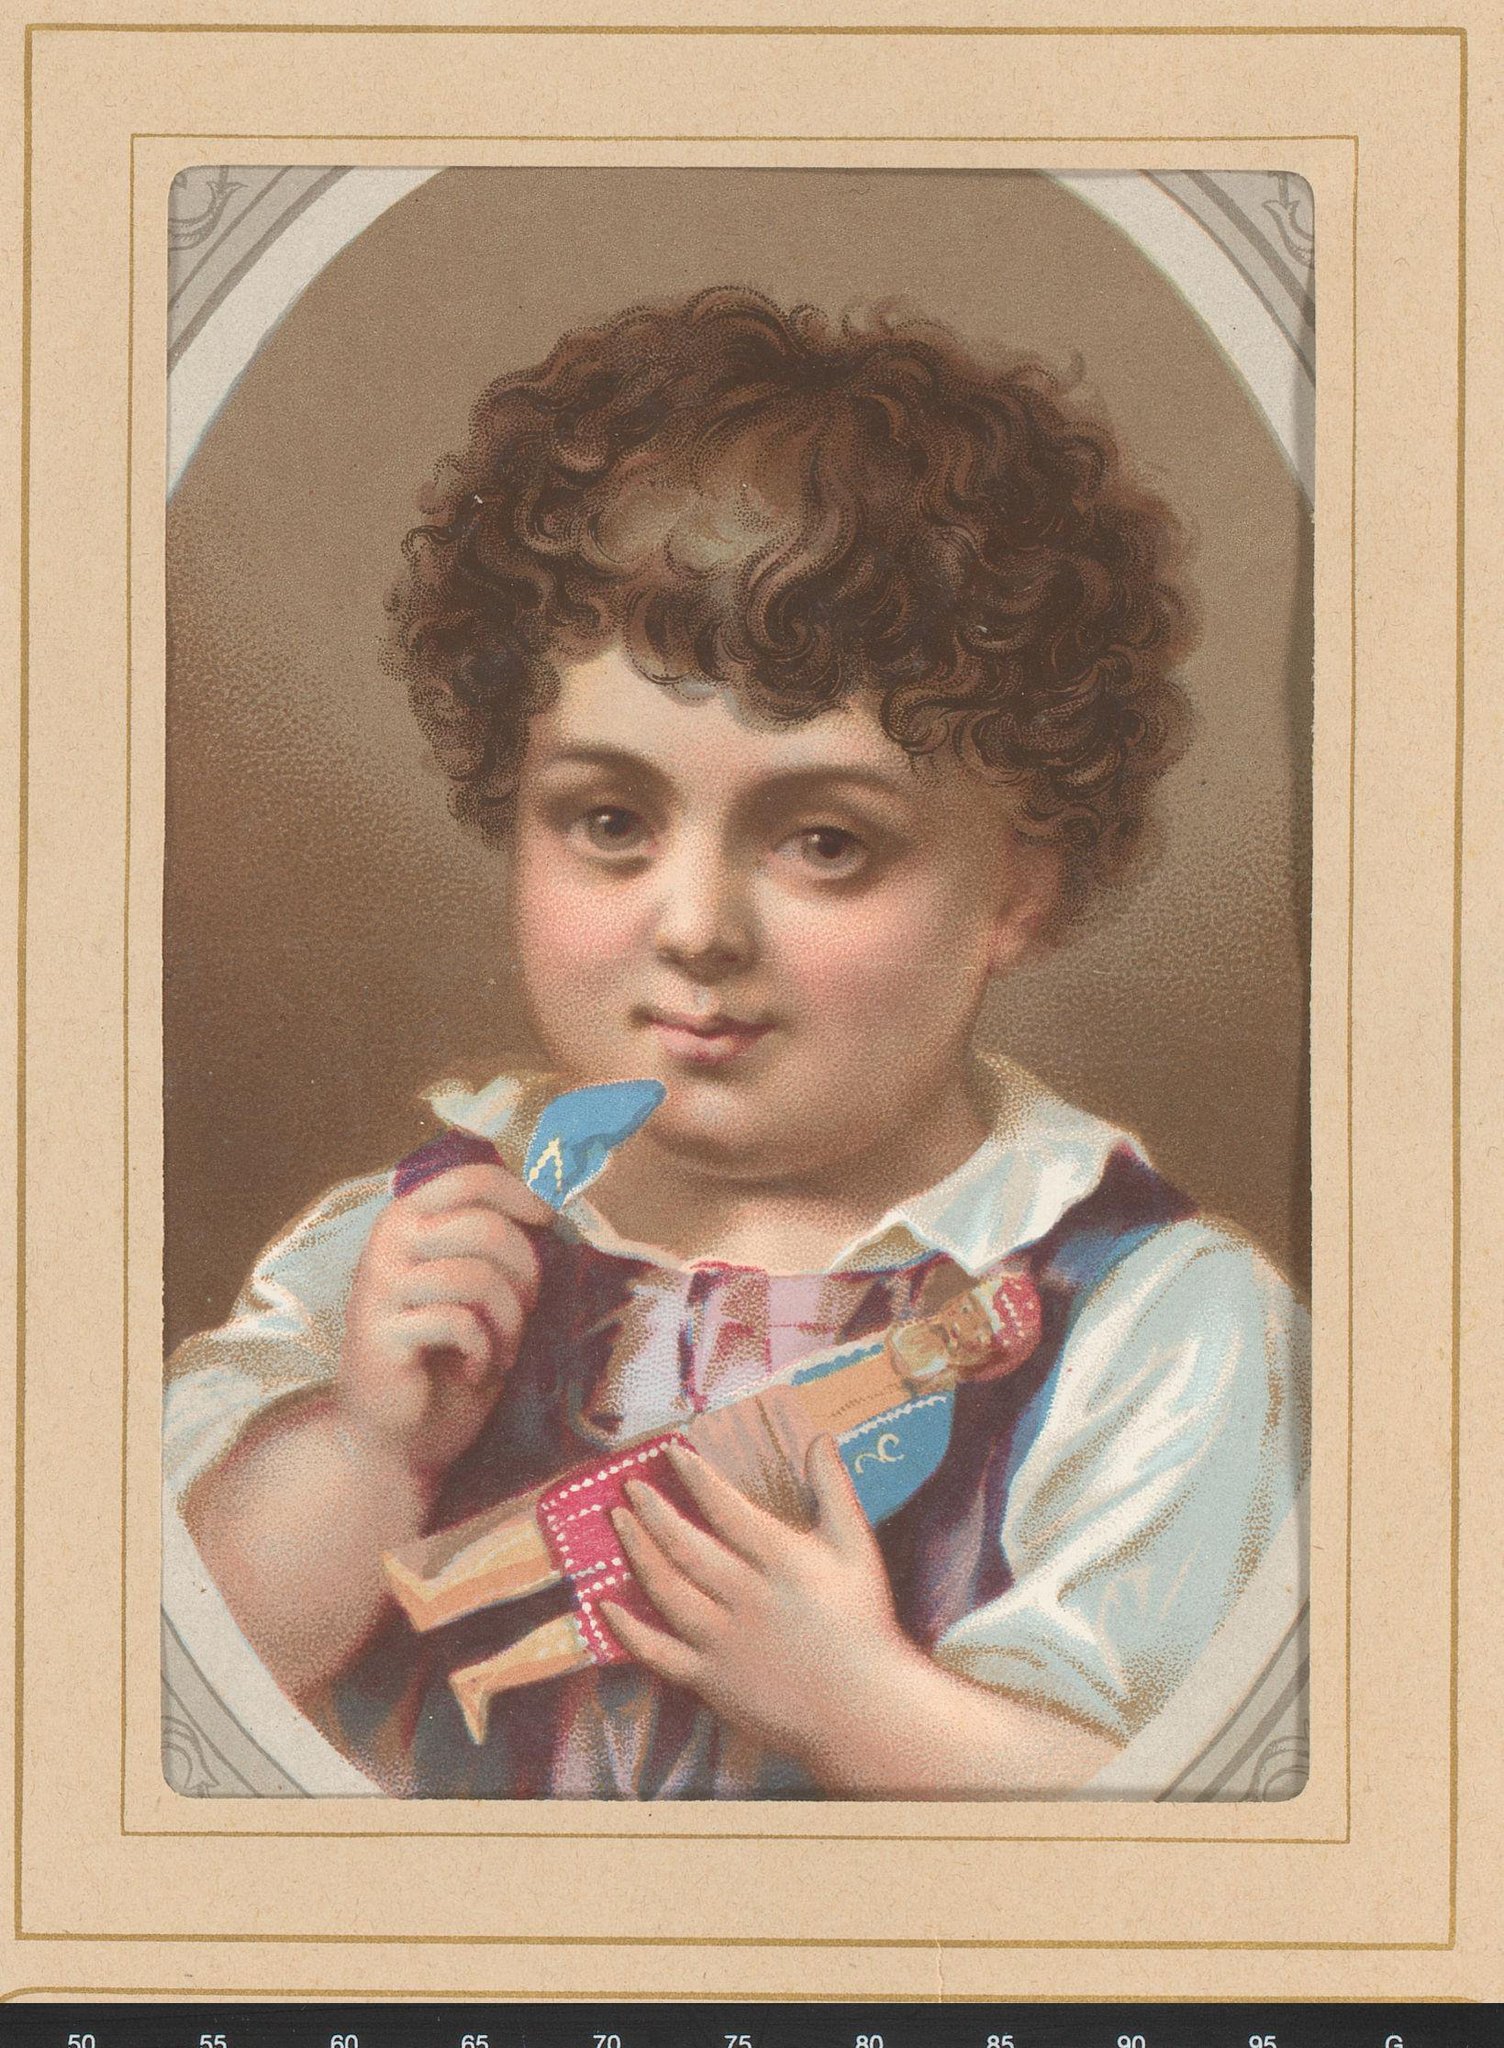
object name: photomechanical print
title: Portret van een jongen met pop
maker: Anonymous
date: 1870-1900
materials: paper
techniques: collotype process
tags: boy (child between toddler and youth), (playing with) dolls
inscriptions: number: ‘818’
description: Deze prent maakt deel uit van een album.